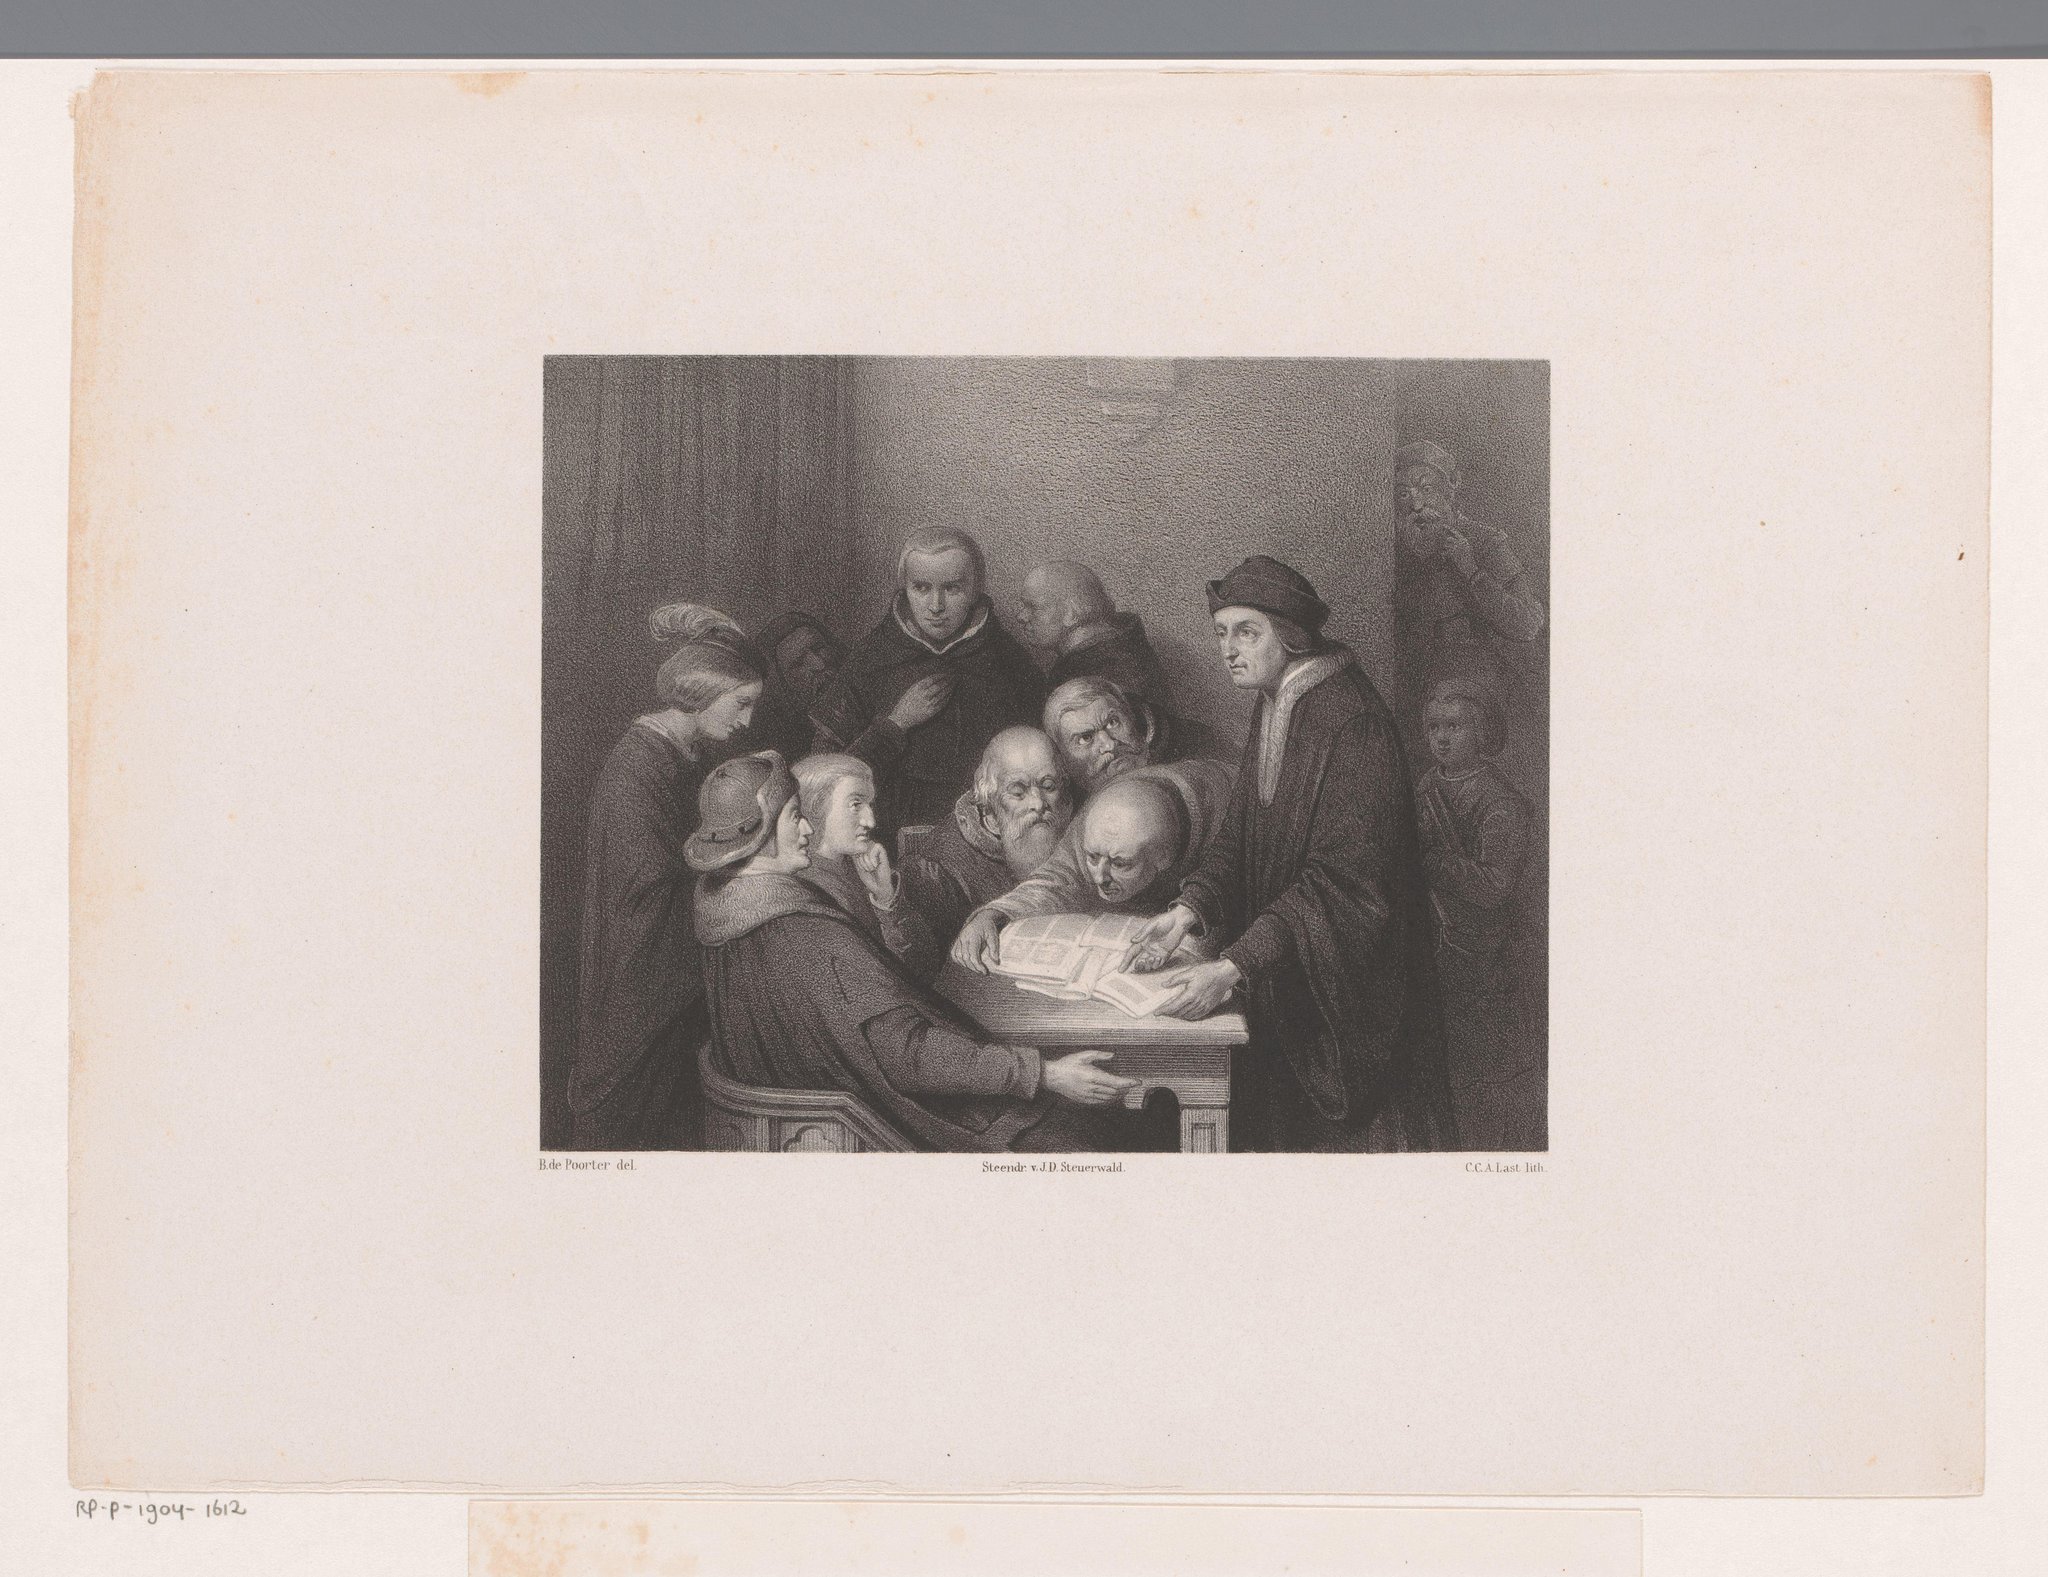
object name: print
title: Groep mannen rond een tafel met papieren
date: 1822-1863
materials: paper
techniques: lithograph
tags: eavesdropper, debate, discussion (~ meeting)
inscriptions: collector's mark: Lugt 2228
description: Twee van de mannen zijn in een verhit gesprek. Een van hen wijst naar de papieren. Rechts, om de hoek, staan een man en kind te luisteren.